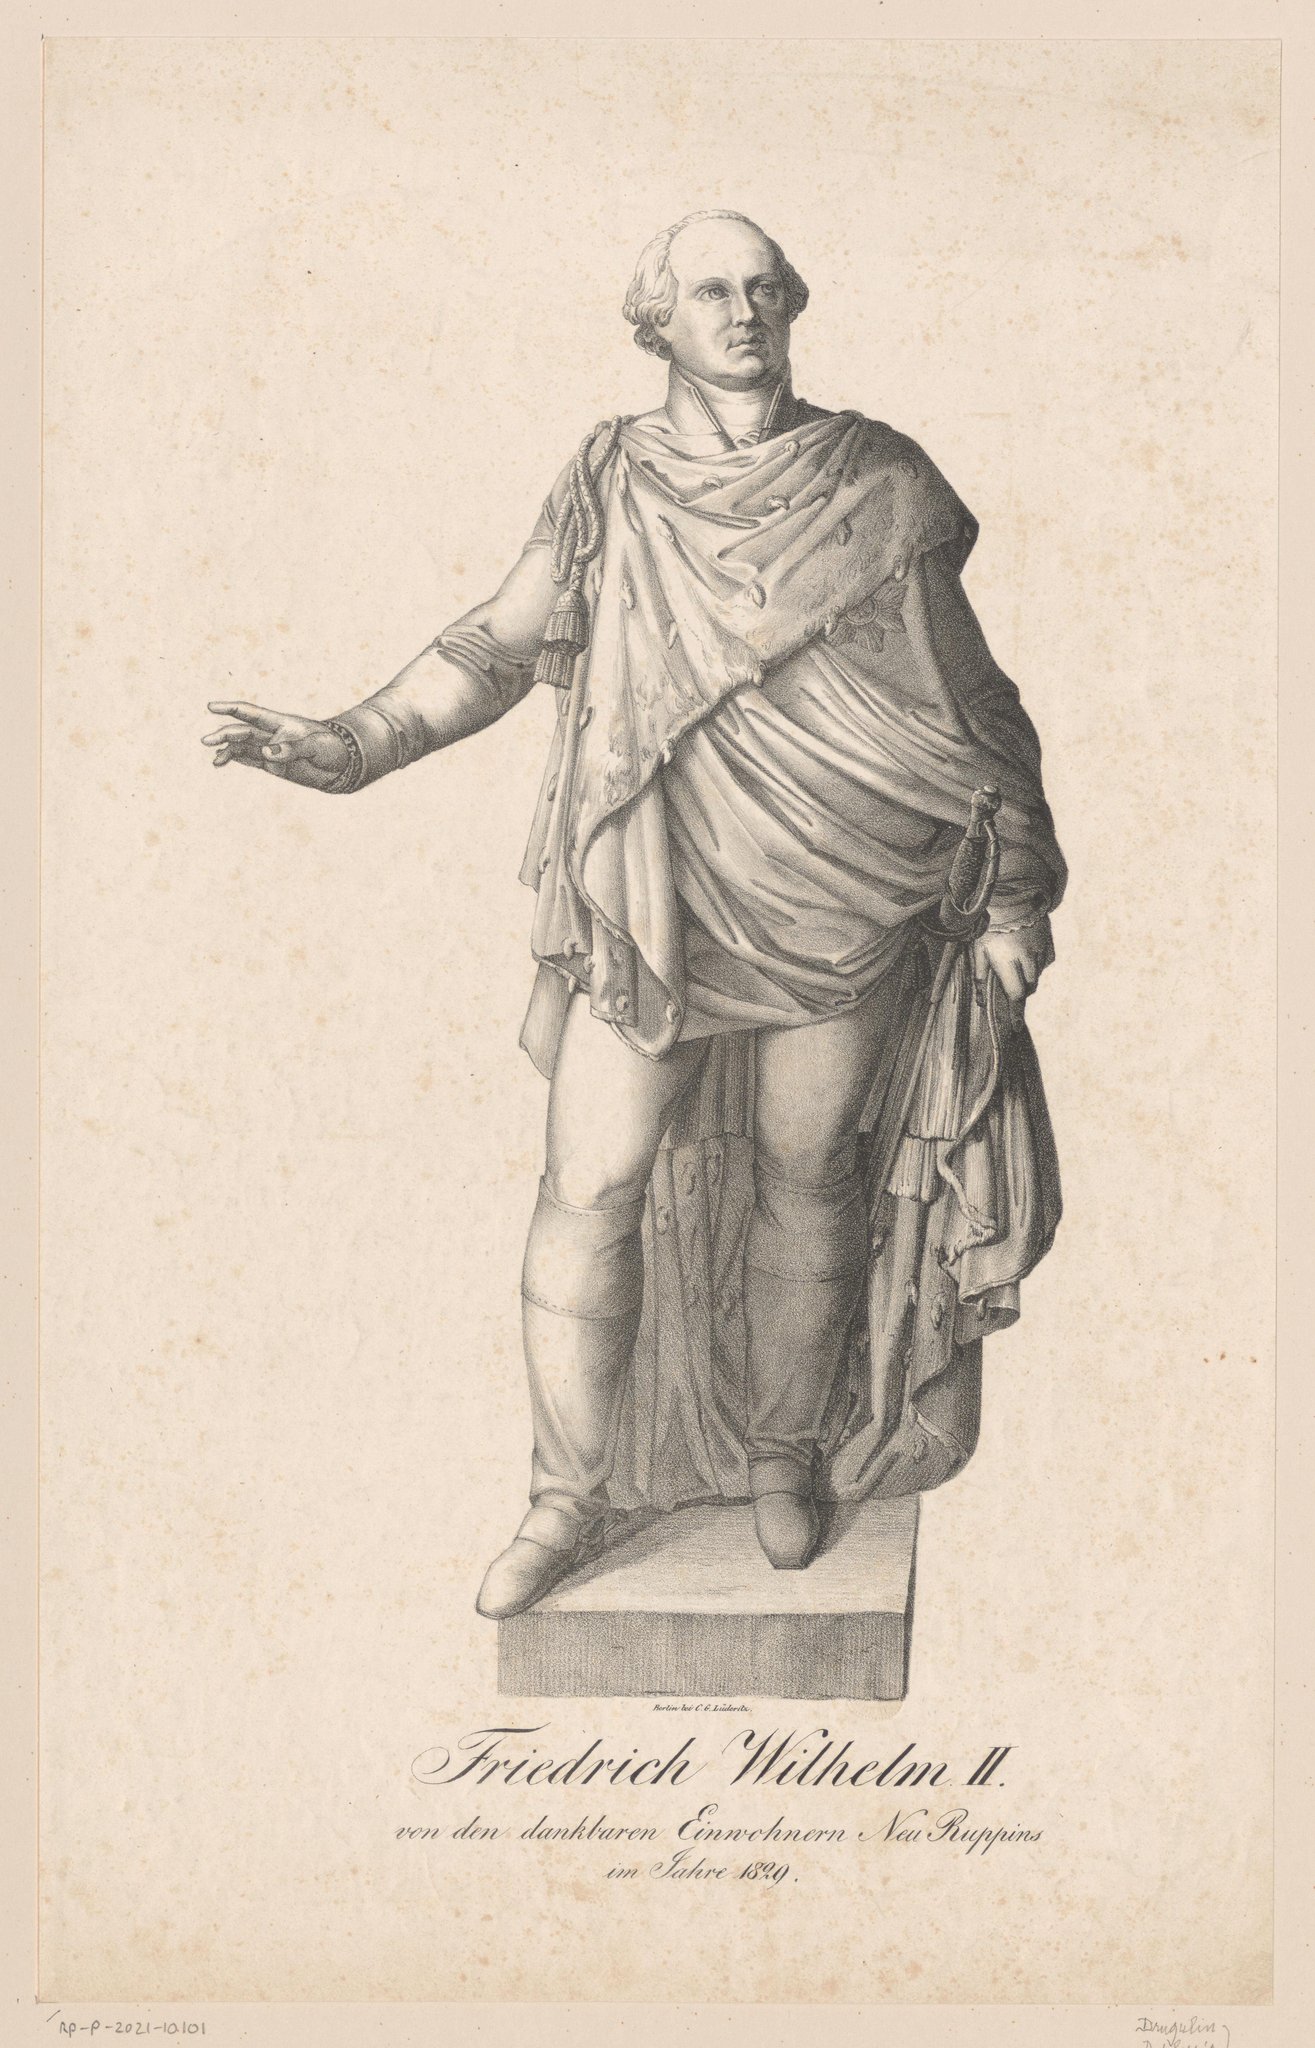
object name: print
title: Standbeeld van Frederik Willem II van Pruisen te Neuruppin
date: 1829-1840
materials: paper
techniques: lithograph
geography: germany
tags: berlin, frederik willem ii (koning van pruisen), historical persons, monument, statue, king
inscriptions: check stamp: Lugt 4519